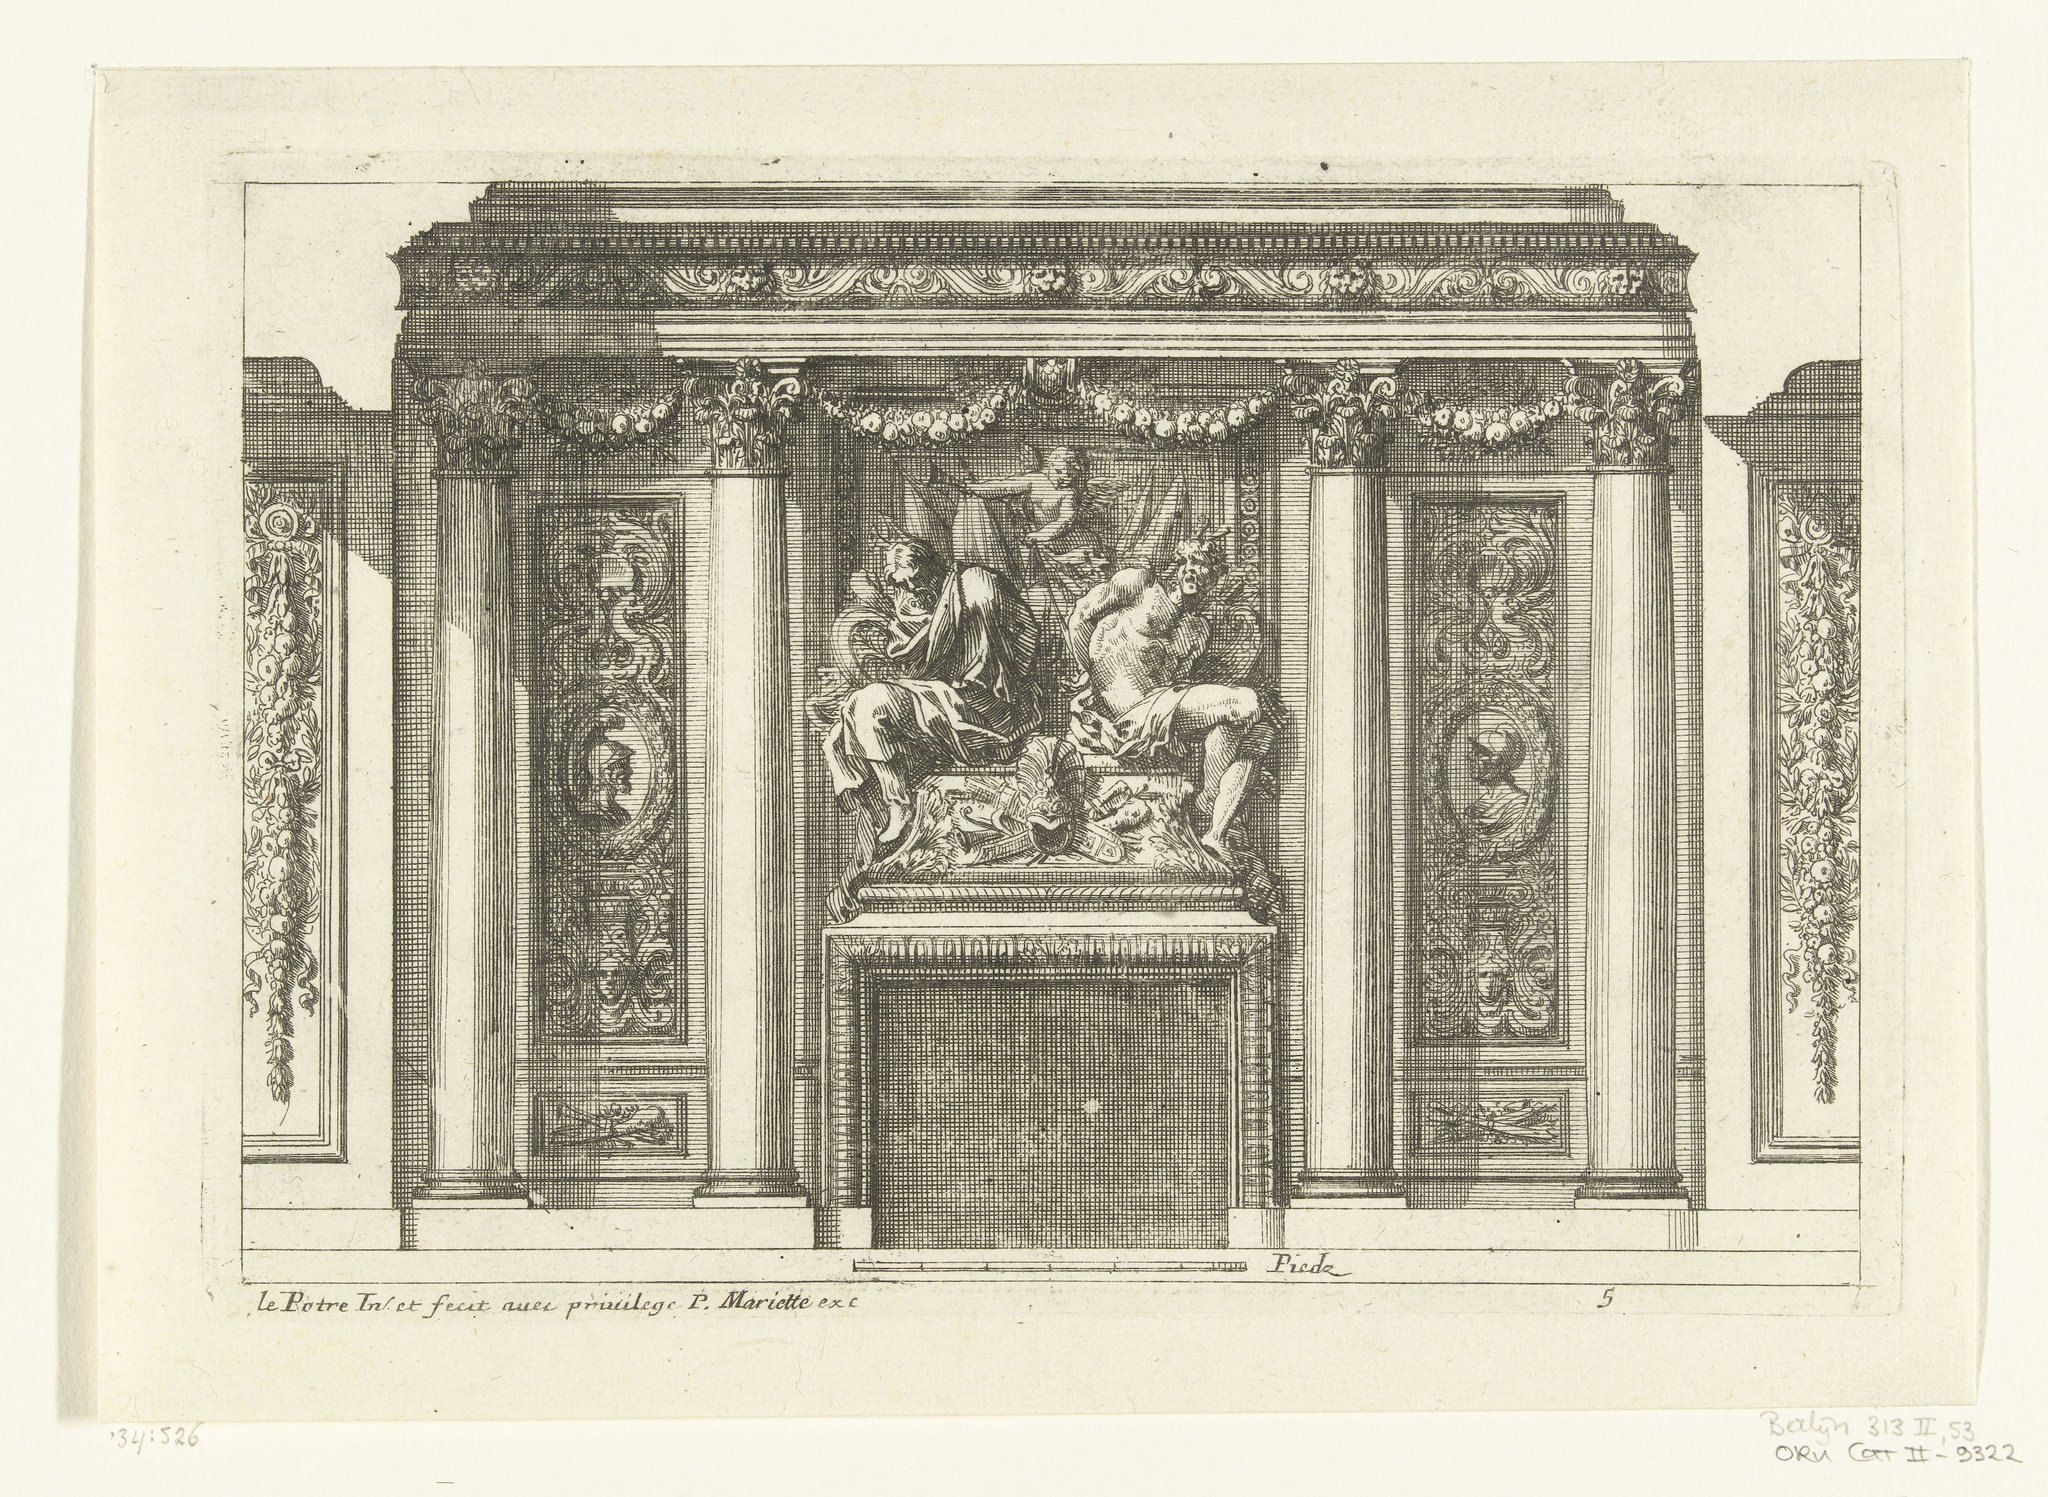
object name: print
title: Schouw met twee geketende gevangenen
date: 1658-1670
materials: paper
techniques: etching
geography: france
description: Doorsnede van een kamer met een schouw met twee geketende gevangenen voor een wapentrofee. Links en rechts twee Korinthische zuilen. Uit tweede editie.